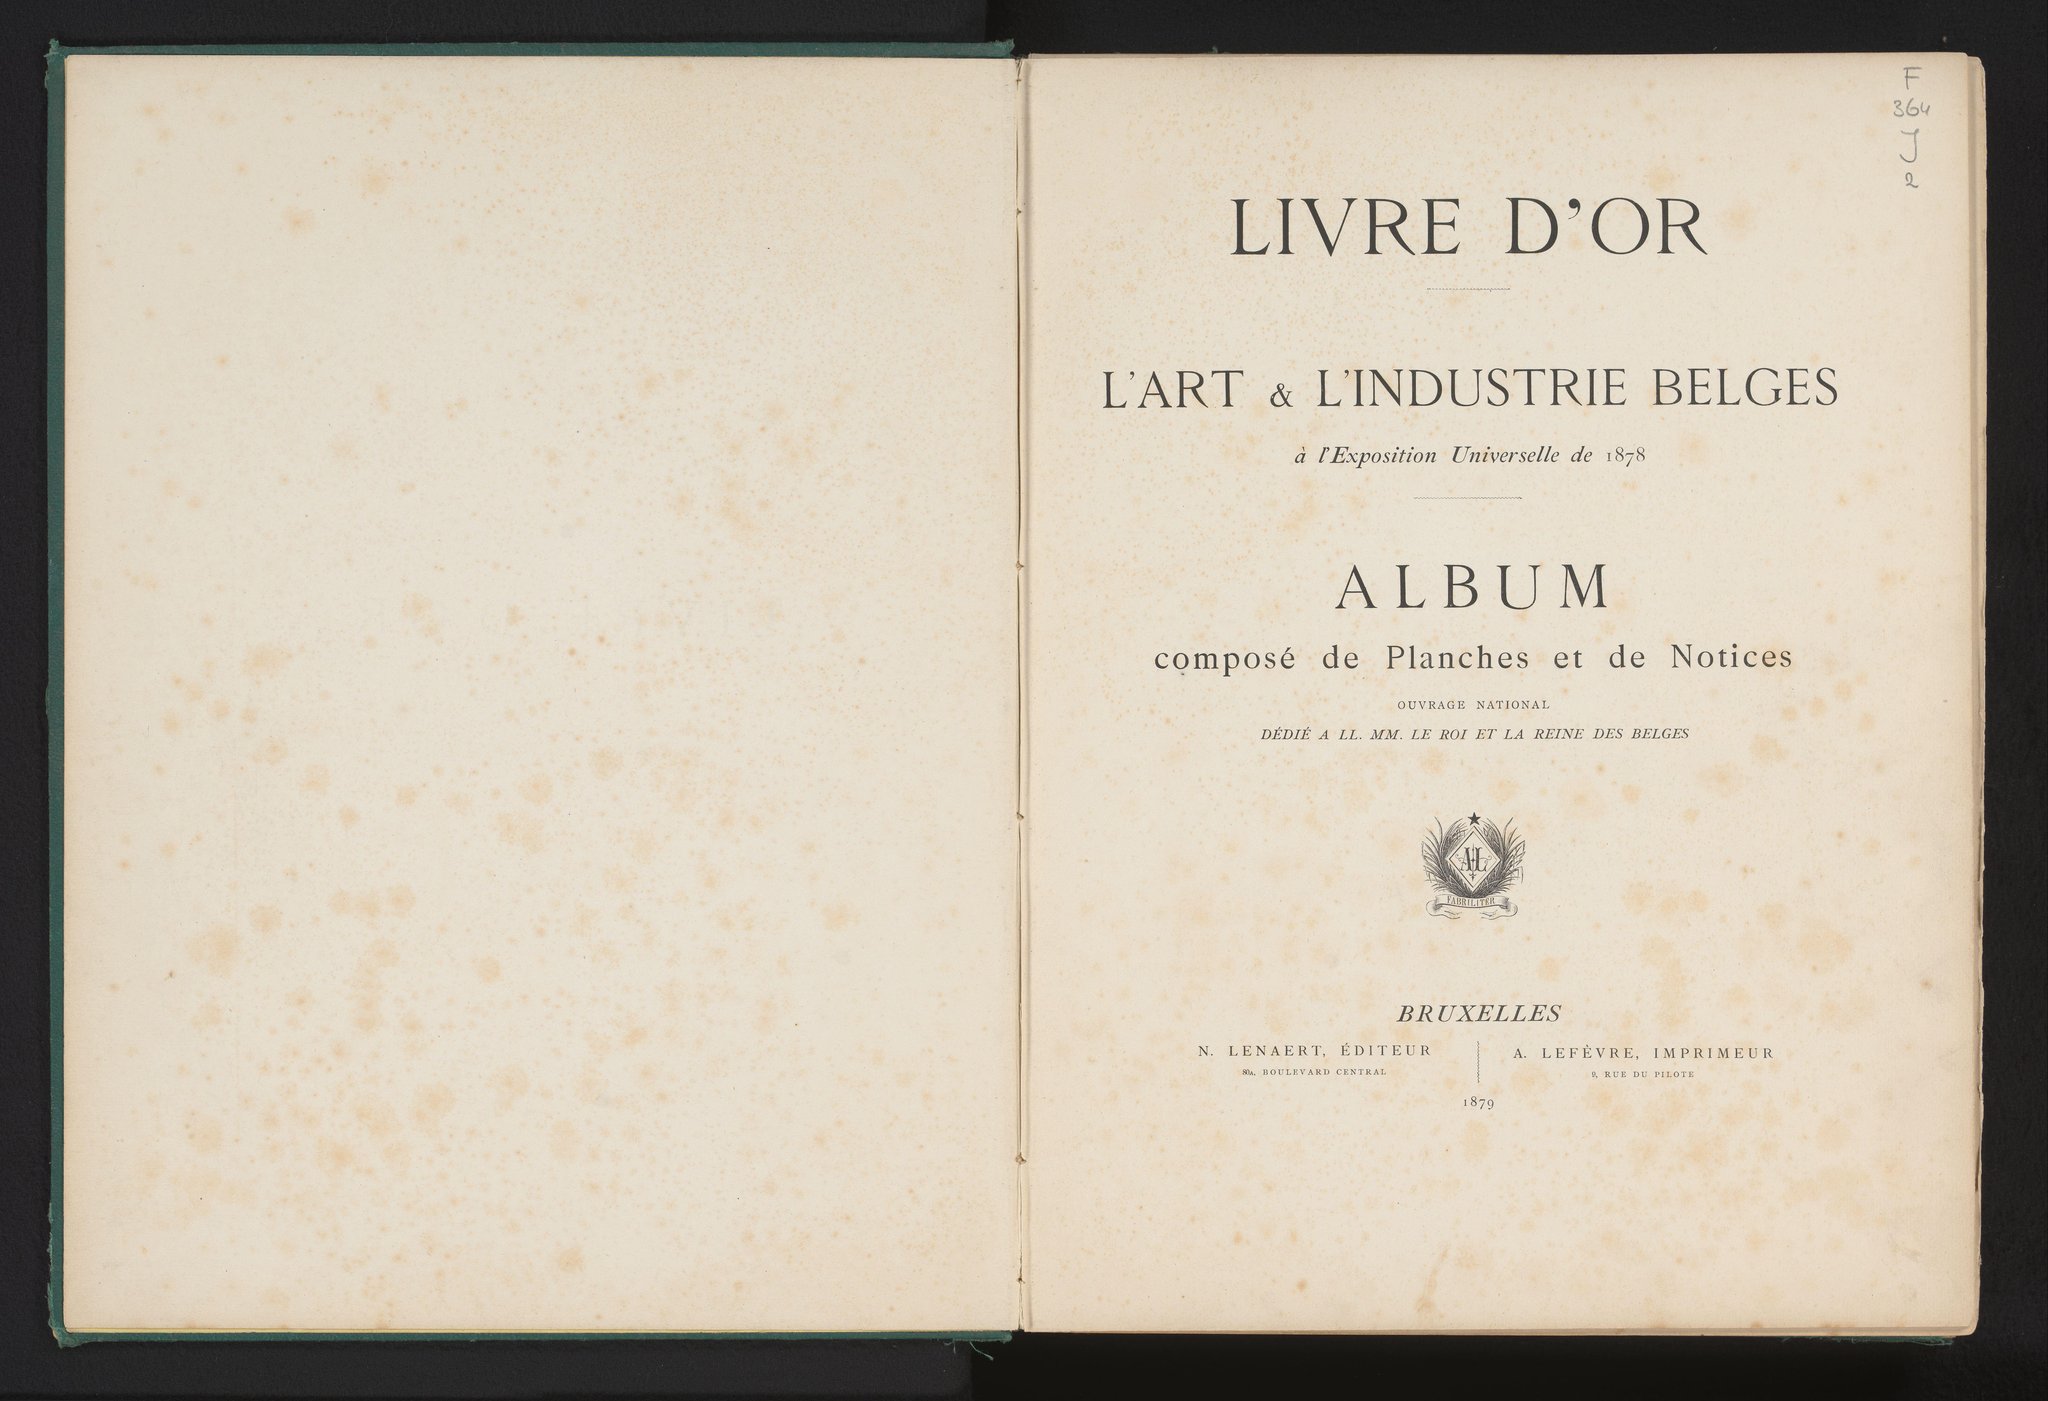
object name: book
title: Livre d'or : l'art et l'industrie belges à l'Exposition universelle de 1878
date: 1879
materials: cardboard, leather, linen, paper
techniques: photograph, printing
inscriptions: date: ‘JAN 2004’